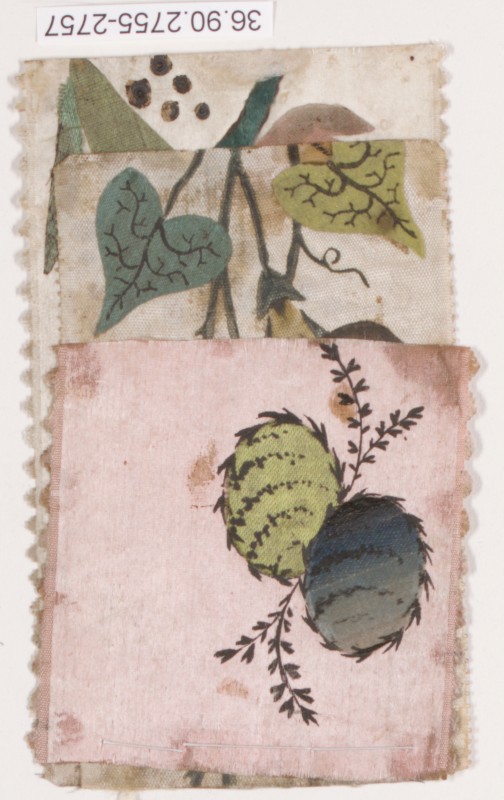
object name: ribbon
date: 1801-1900